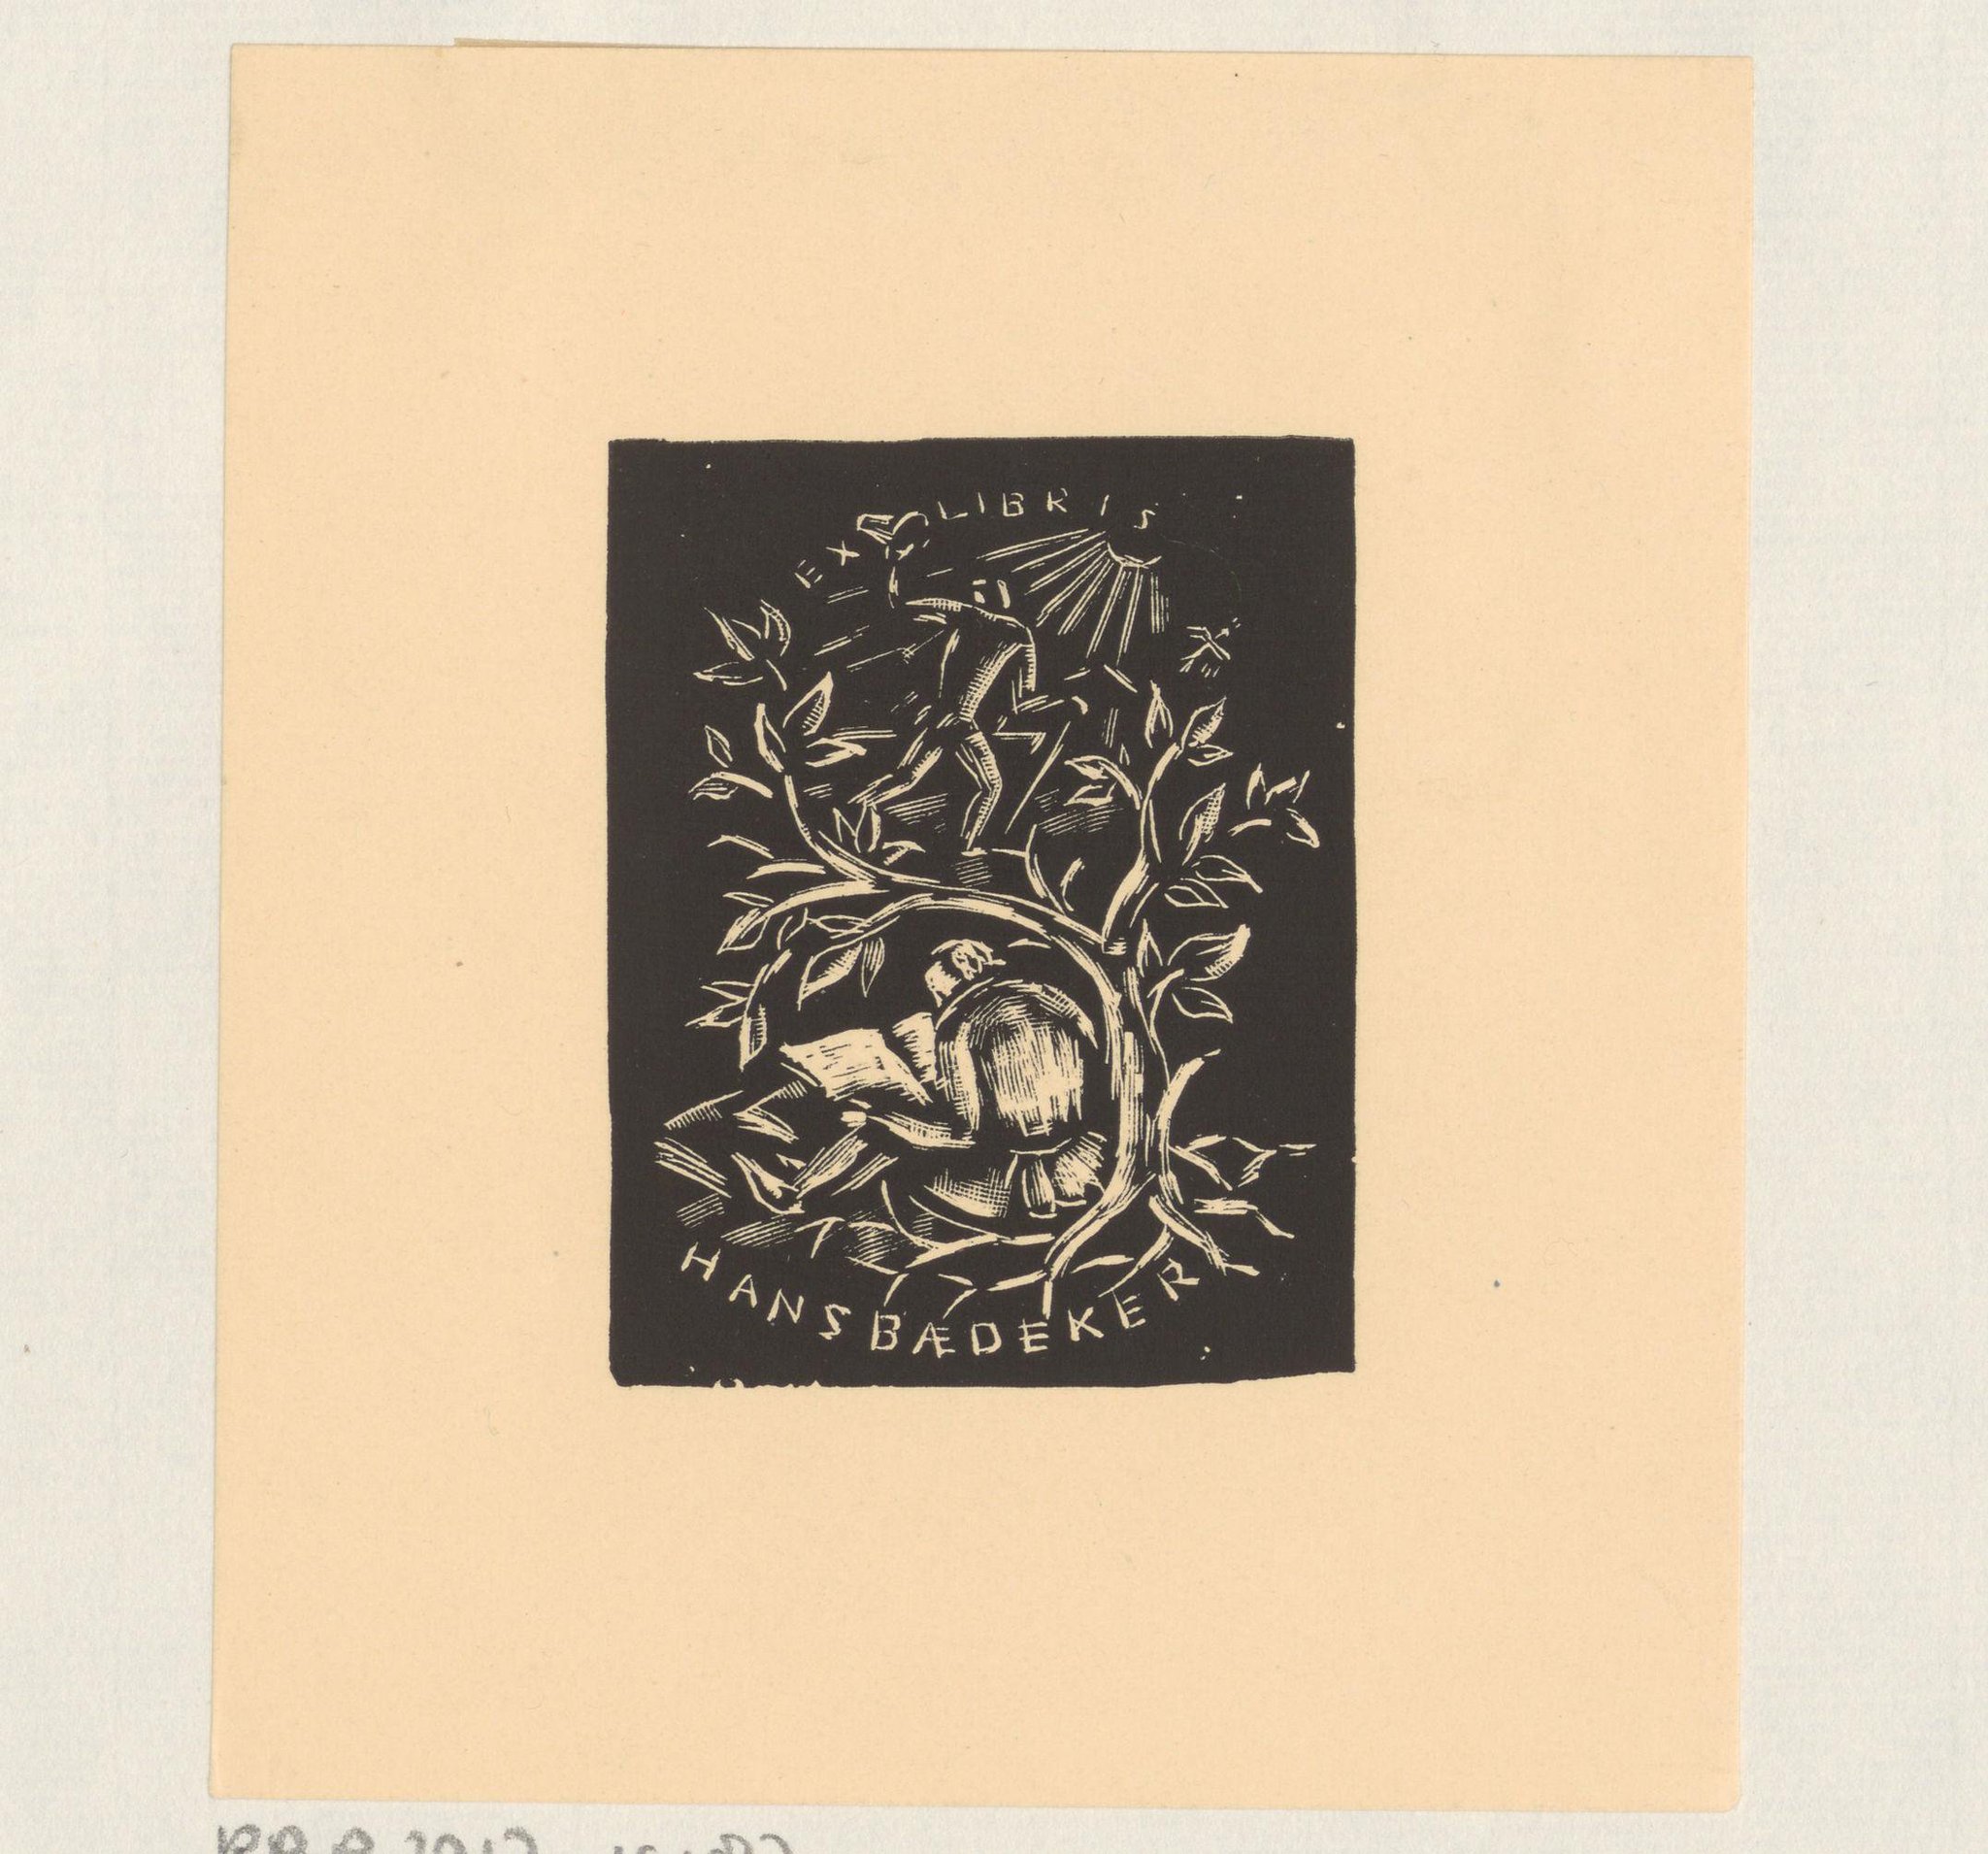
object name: bookplate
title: Ex libris van Hans Baedeker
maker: adalbert duntze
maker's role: print maker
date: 1900-1959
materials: paper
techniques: woodcut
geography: germany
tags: trees, sitting figure, walking, hiking (recreation)